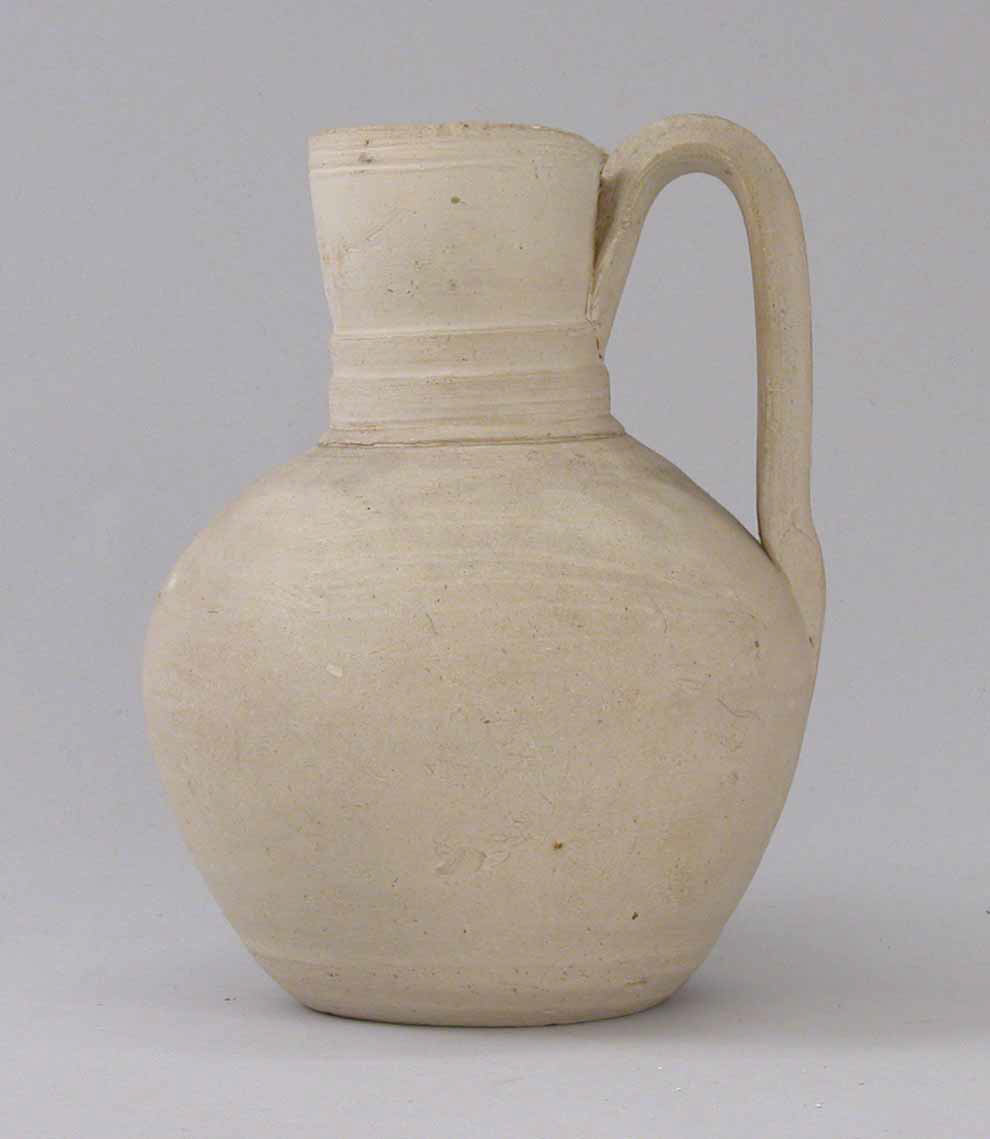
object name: ewer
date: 801-1000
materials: earthenware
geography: iran